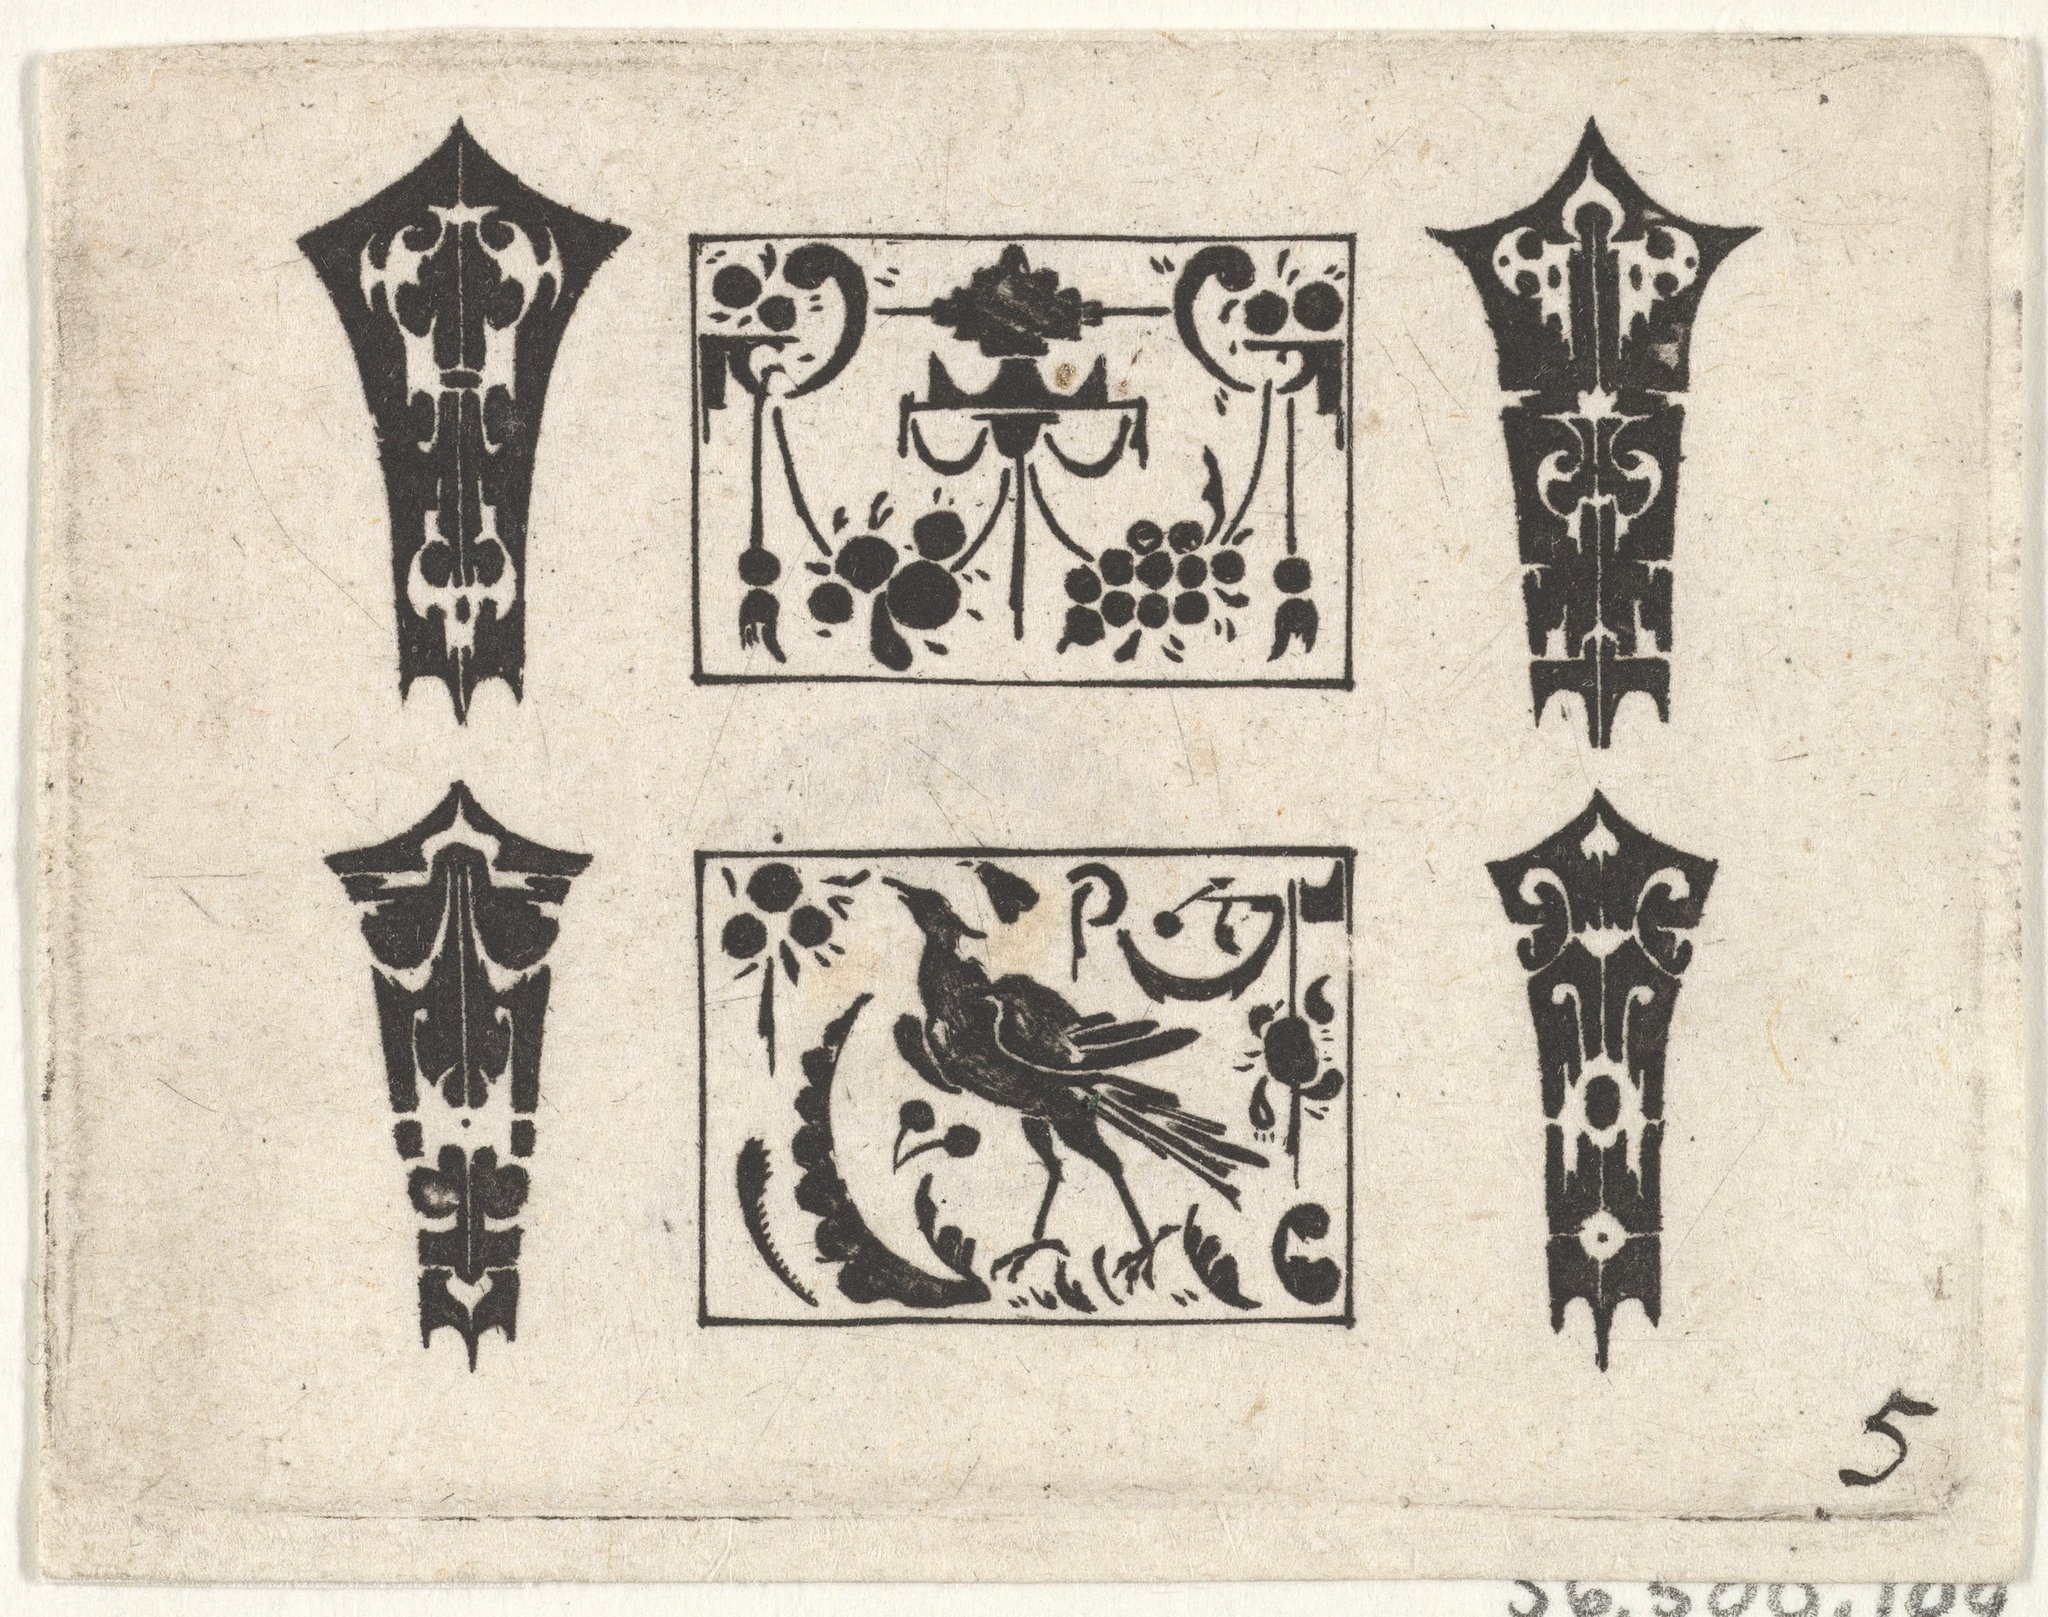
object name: print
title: Blackwork Print with a Symmetrical Schweifwerk Pattern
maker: claes jansz. visscher (ii)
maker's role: artist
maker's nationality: dutch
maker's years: 1586-1652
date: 1620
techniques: embroidery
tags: birds